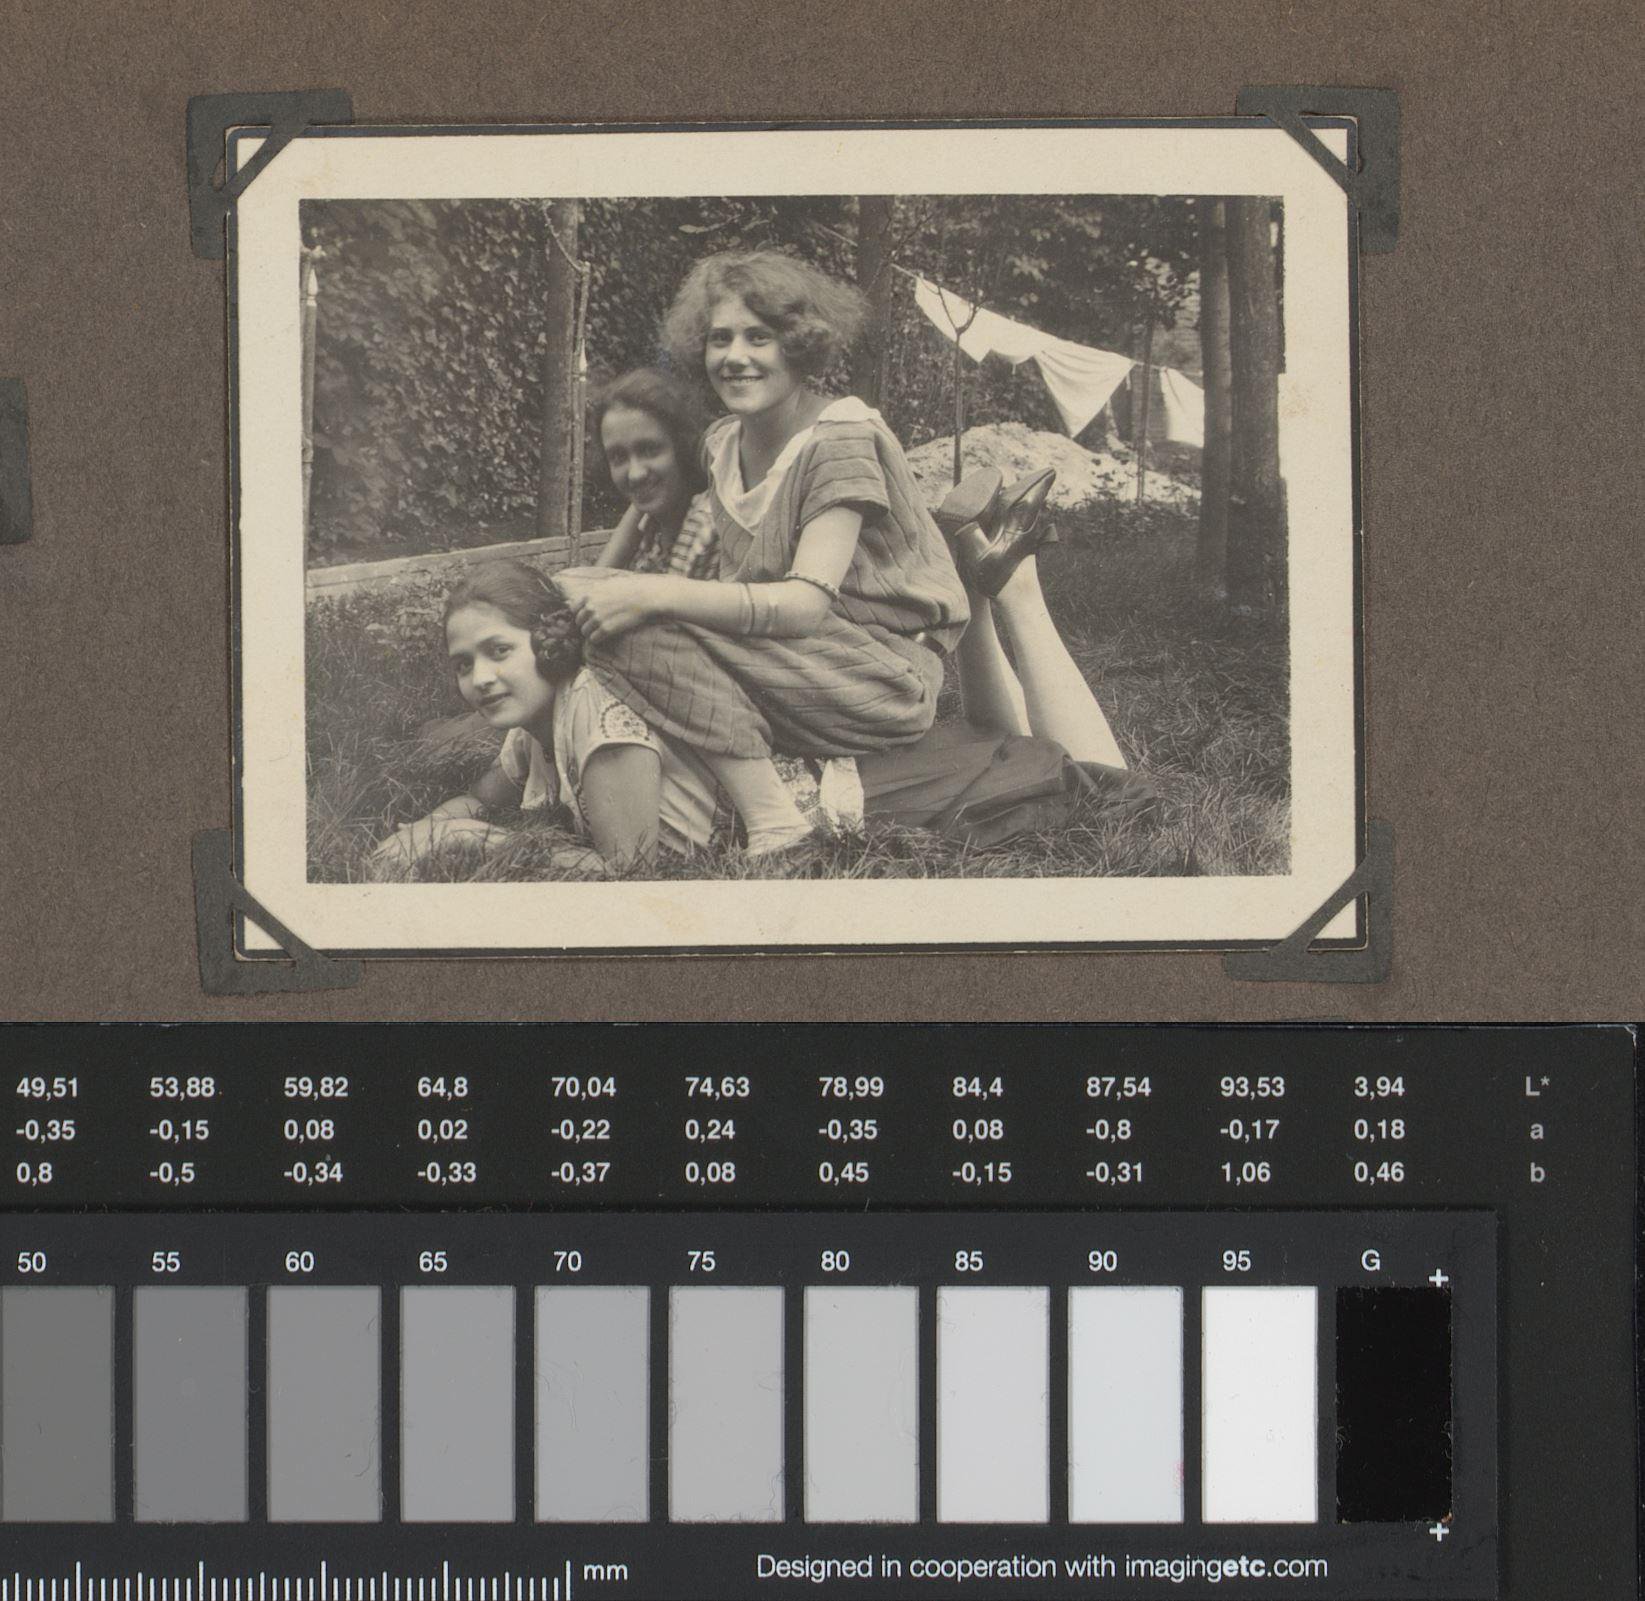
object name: album leaf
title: Wilhelmina en Dootje van Zijll de Jong met een onbekende in een tuin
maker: Anonymous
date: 1930-1935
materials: paper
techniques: gelatin silver print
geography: netherlands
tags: amsterdam, the hague, wilhelmina van zijll de jong, adolescent, young woman, maiden, friends, netherlands